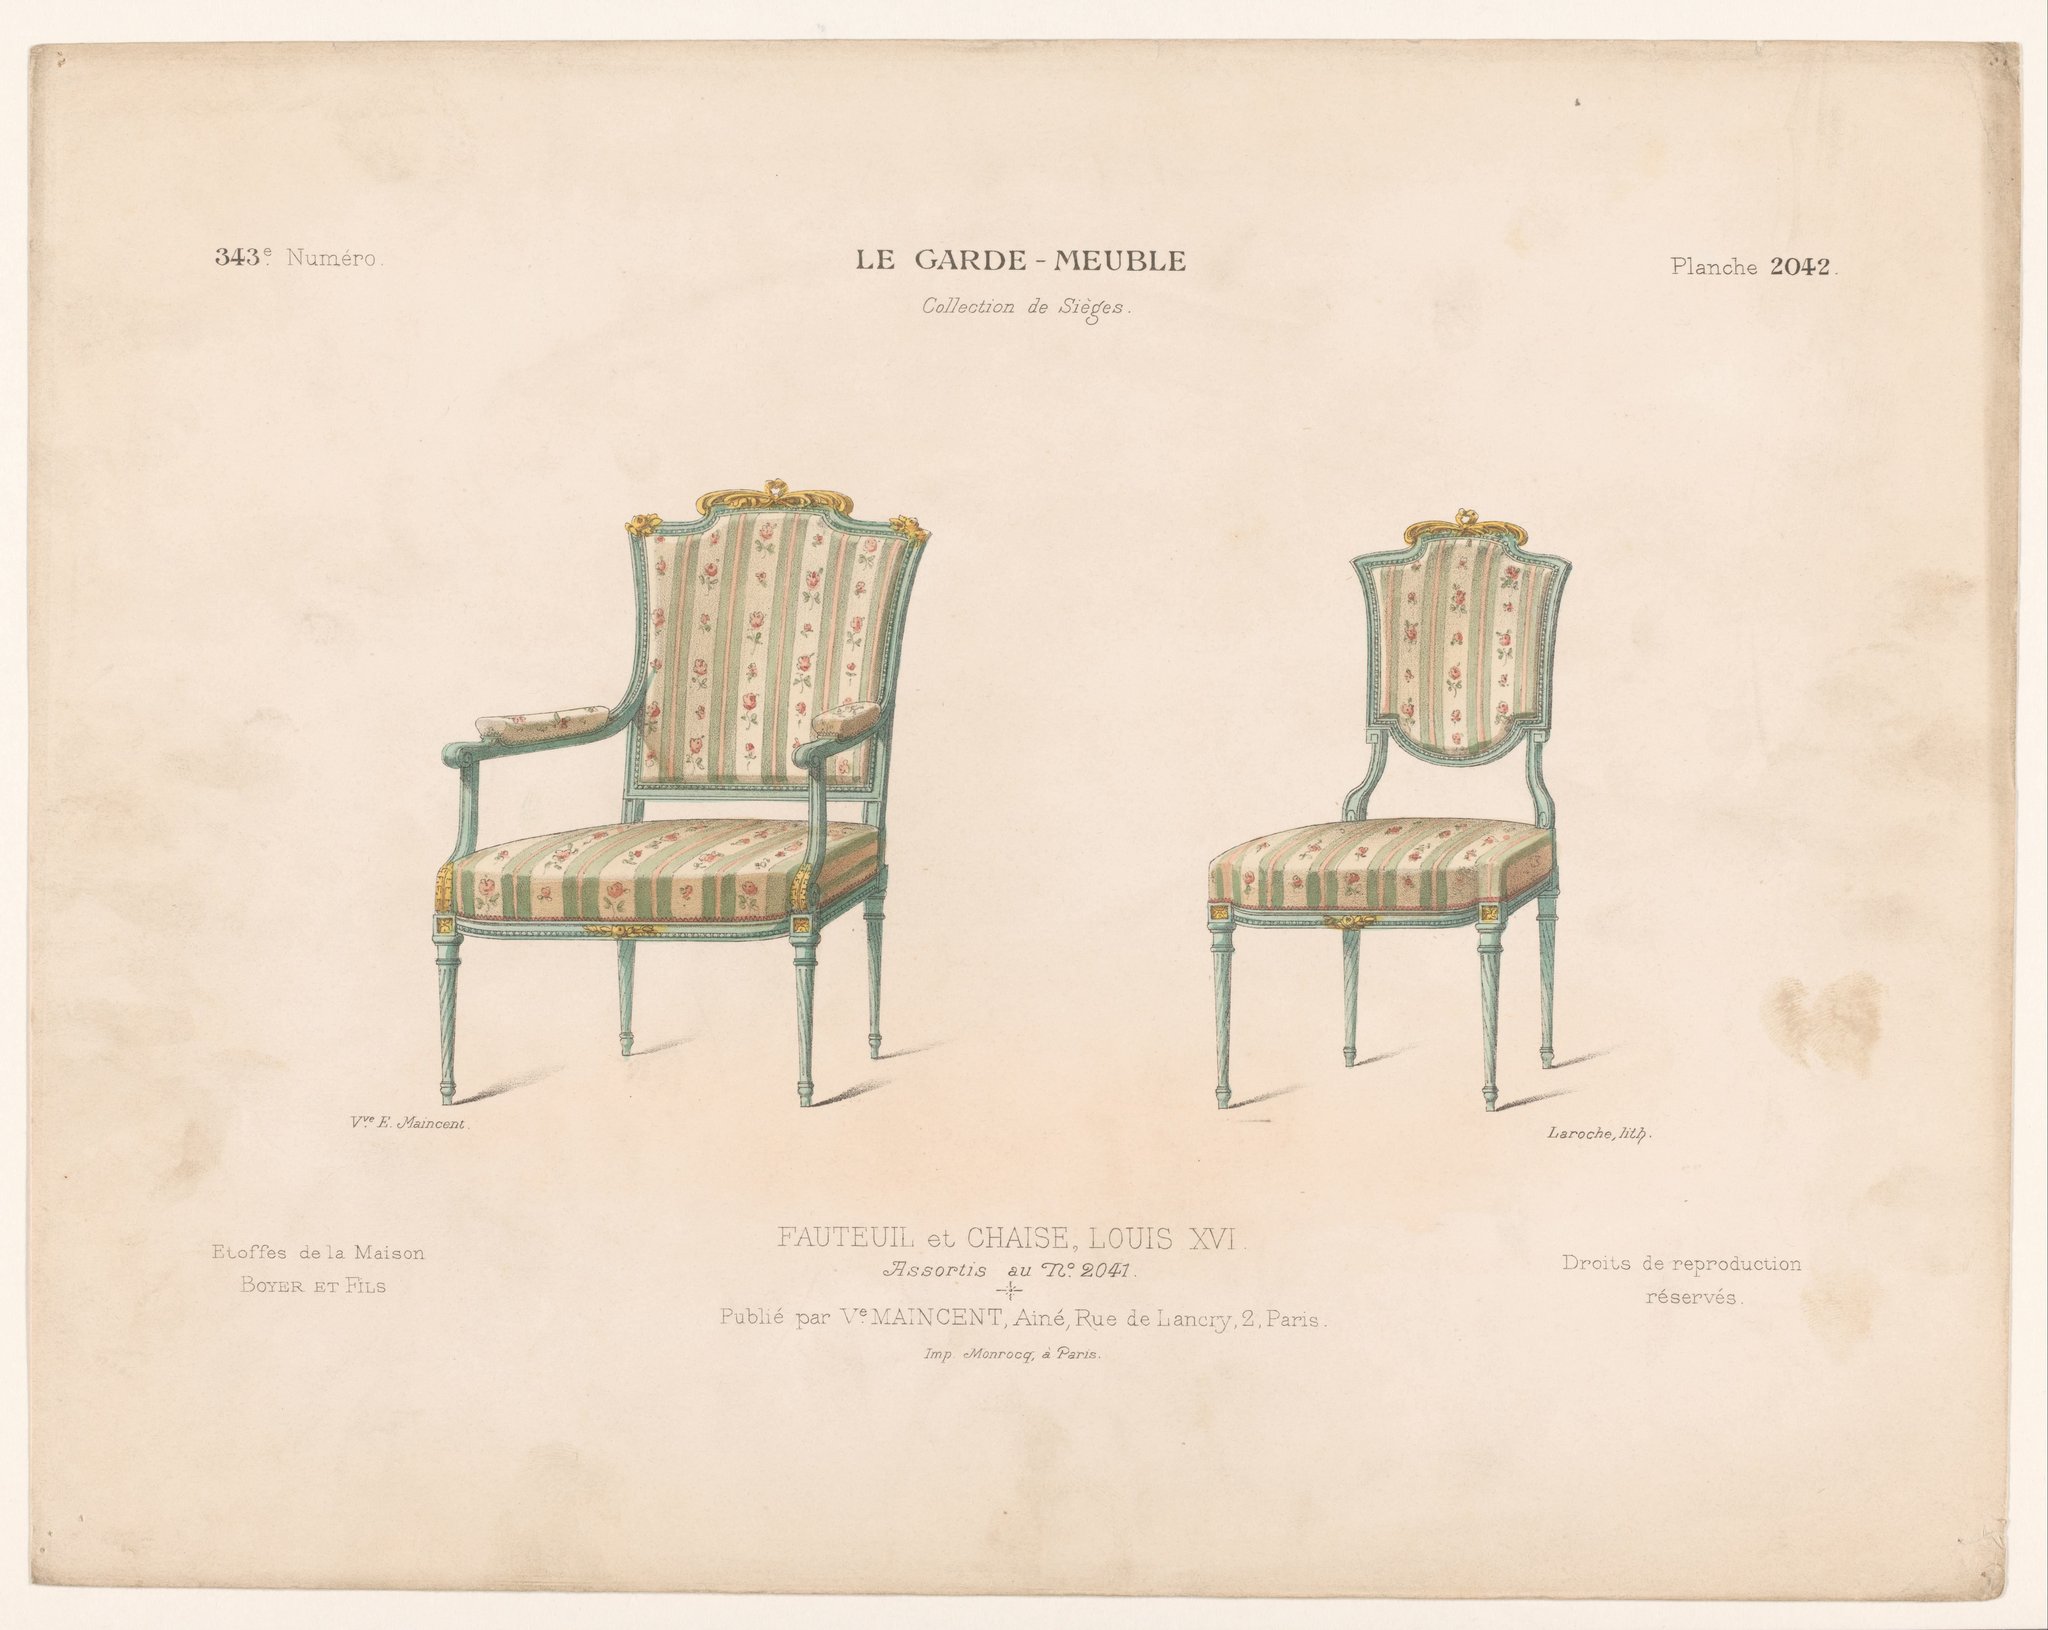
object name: print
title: Fauteuil en stoel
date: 1895-1935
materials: paper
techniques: hand coloring, lithograph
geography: paris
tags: seating furniture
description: Ieder Livraison in de serie Le Garde-Meuble bevat negen platen: drie 'sièges' (zitmeubels), drie 'meubles' (diverse meubels zoals tafels en kasten) en drie 'tentures' (gordijnen en draperieën).